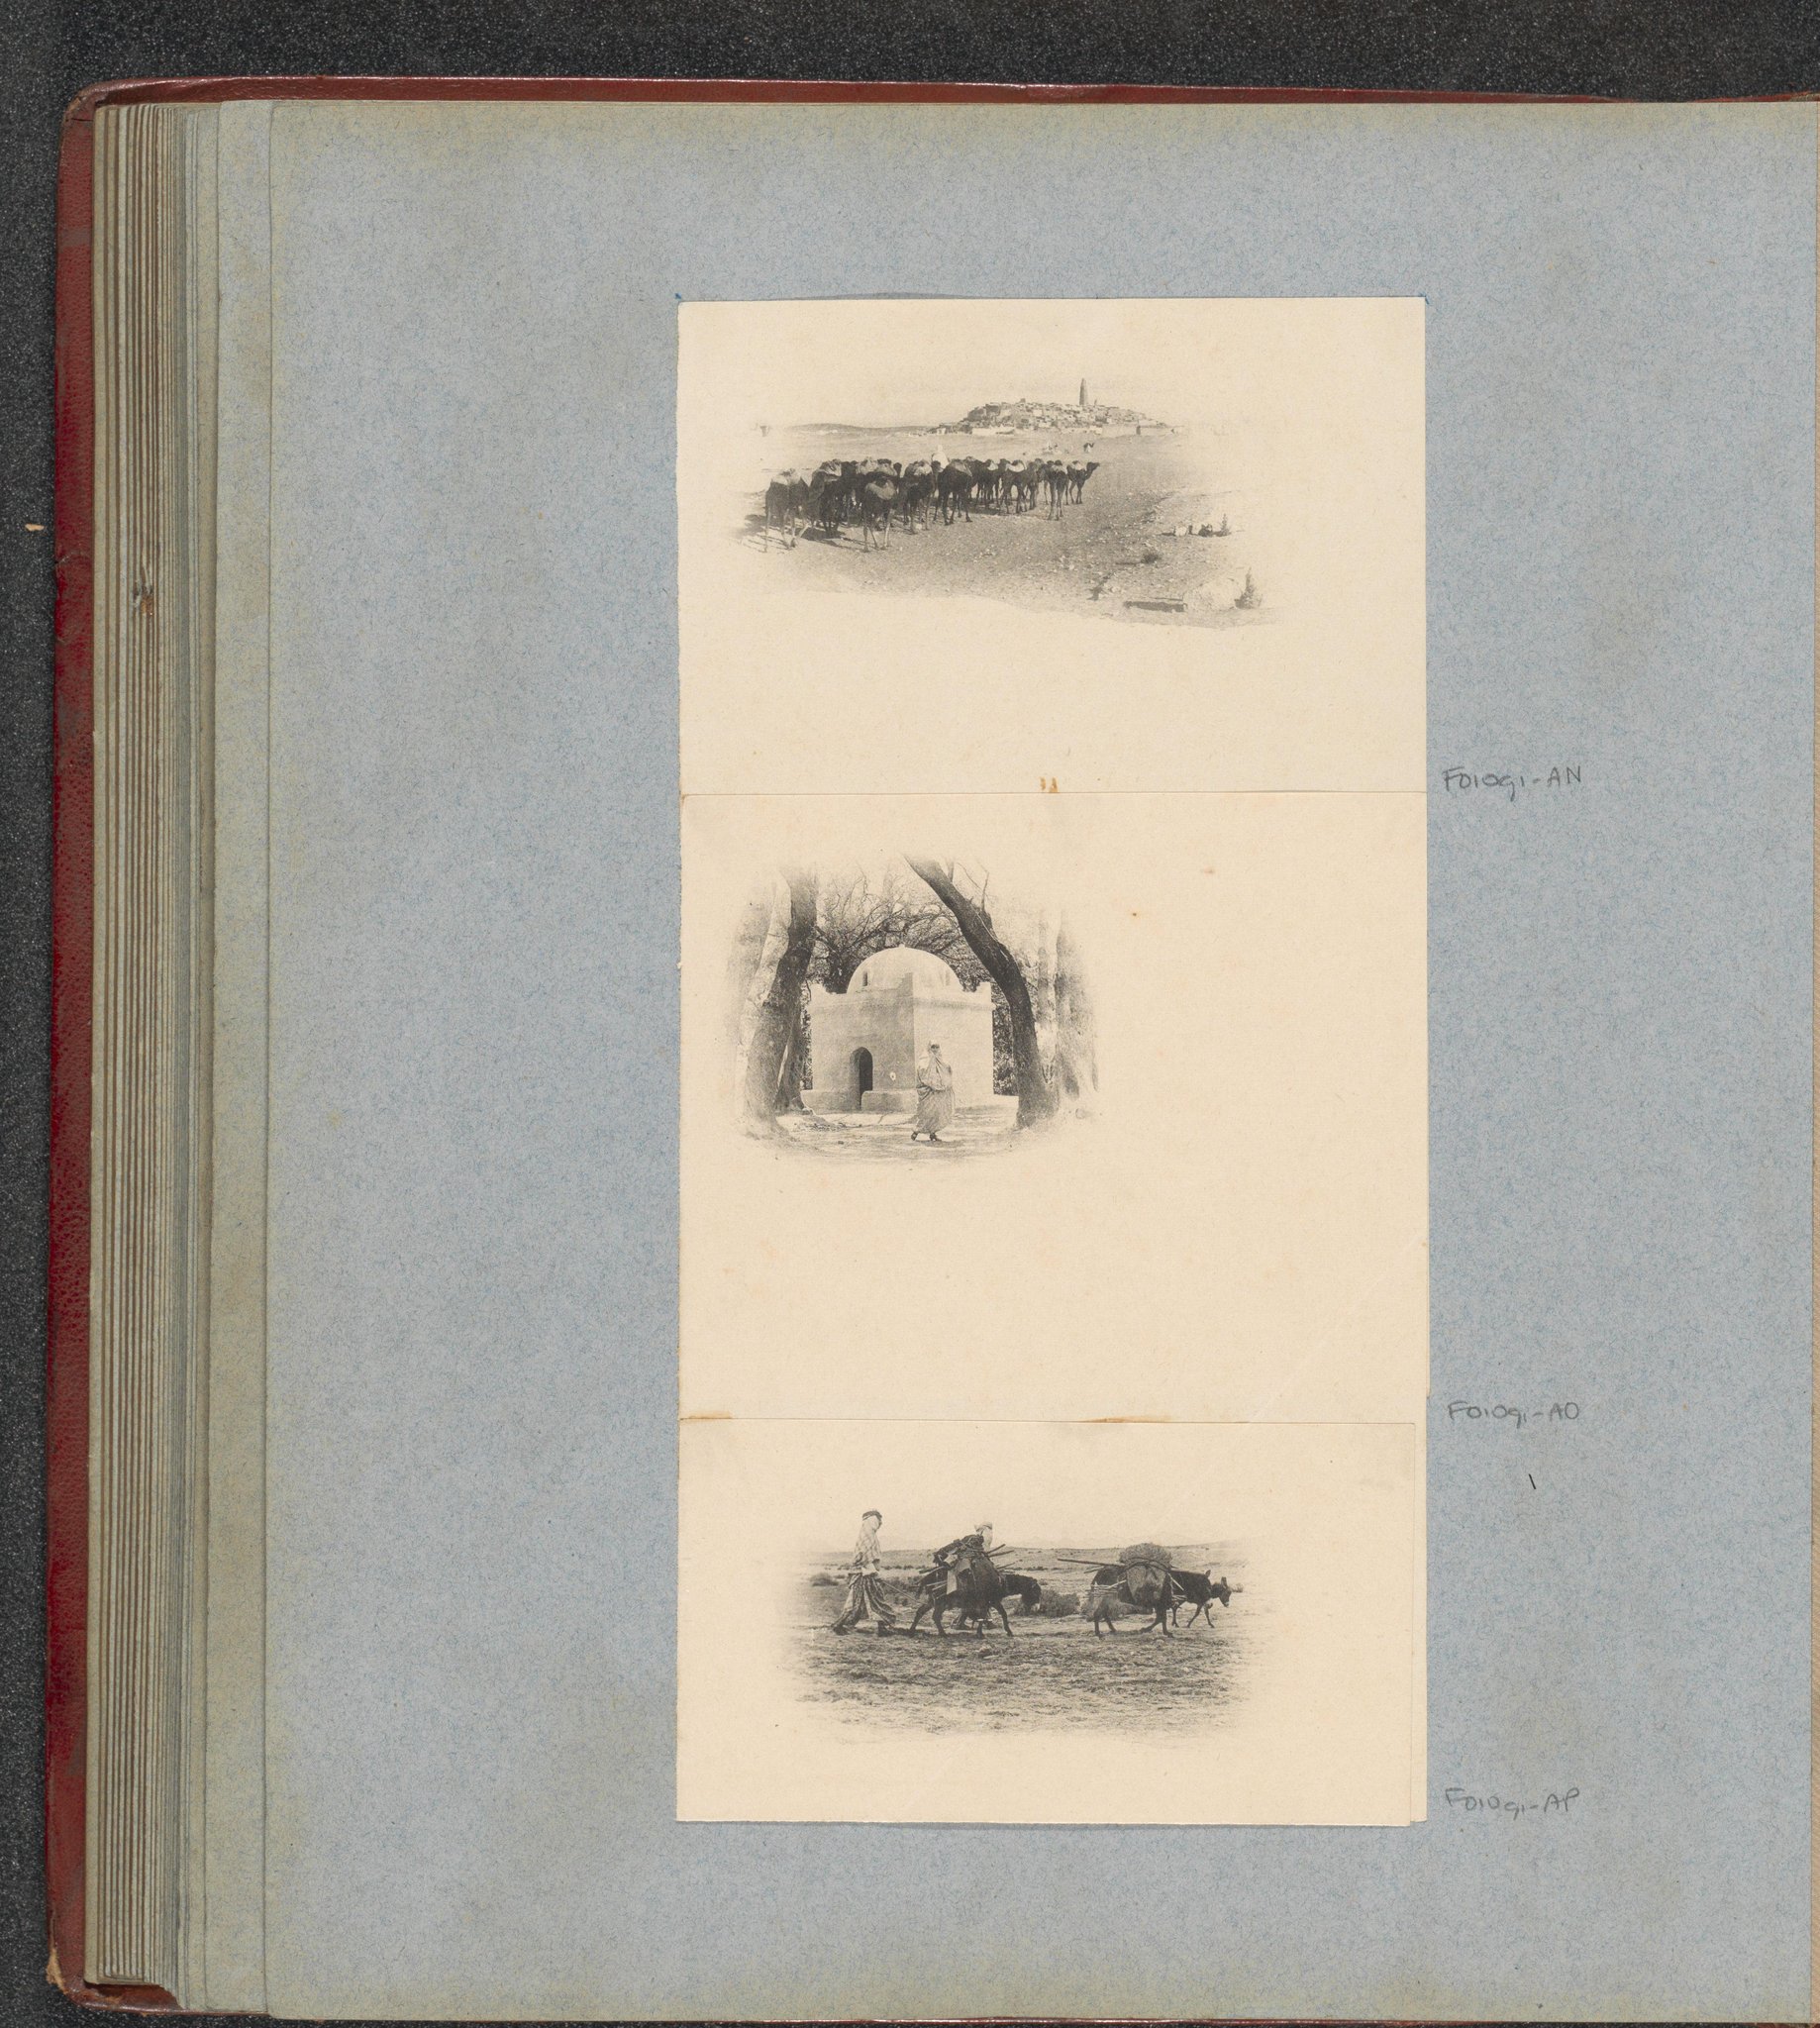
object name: album leaf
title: Ezeldrijvers met hun dieren in Tunesië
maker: Anonymous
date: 1880-1900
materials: paper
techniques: photograph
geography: tunisia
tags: ass, donkey, cattle driving, cattle driver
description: Onderdeel van Reisalbum met foto's van bezienswaardigheden in Tunis en Tunesië.